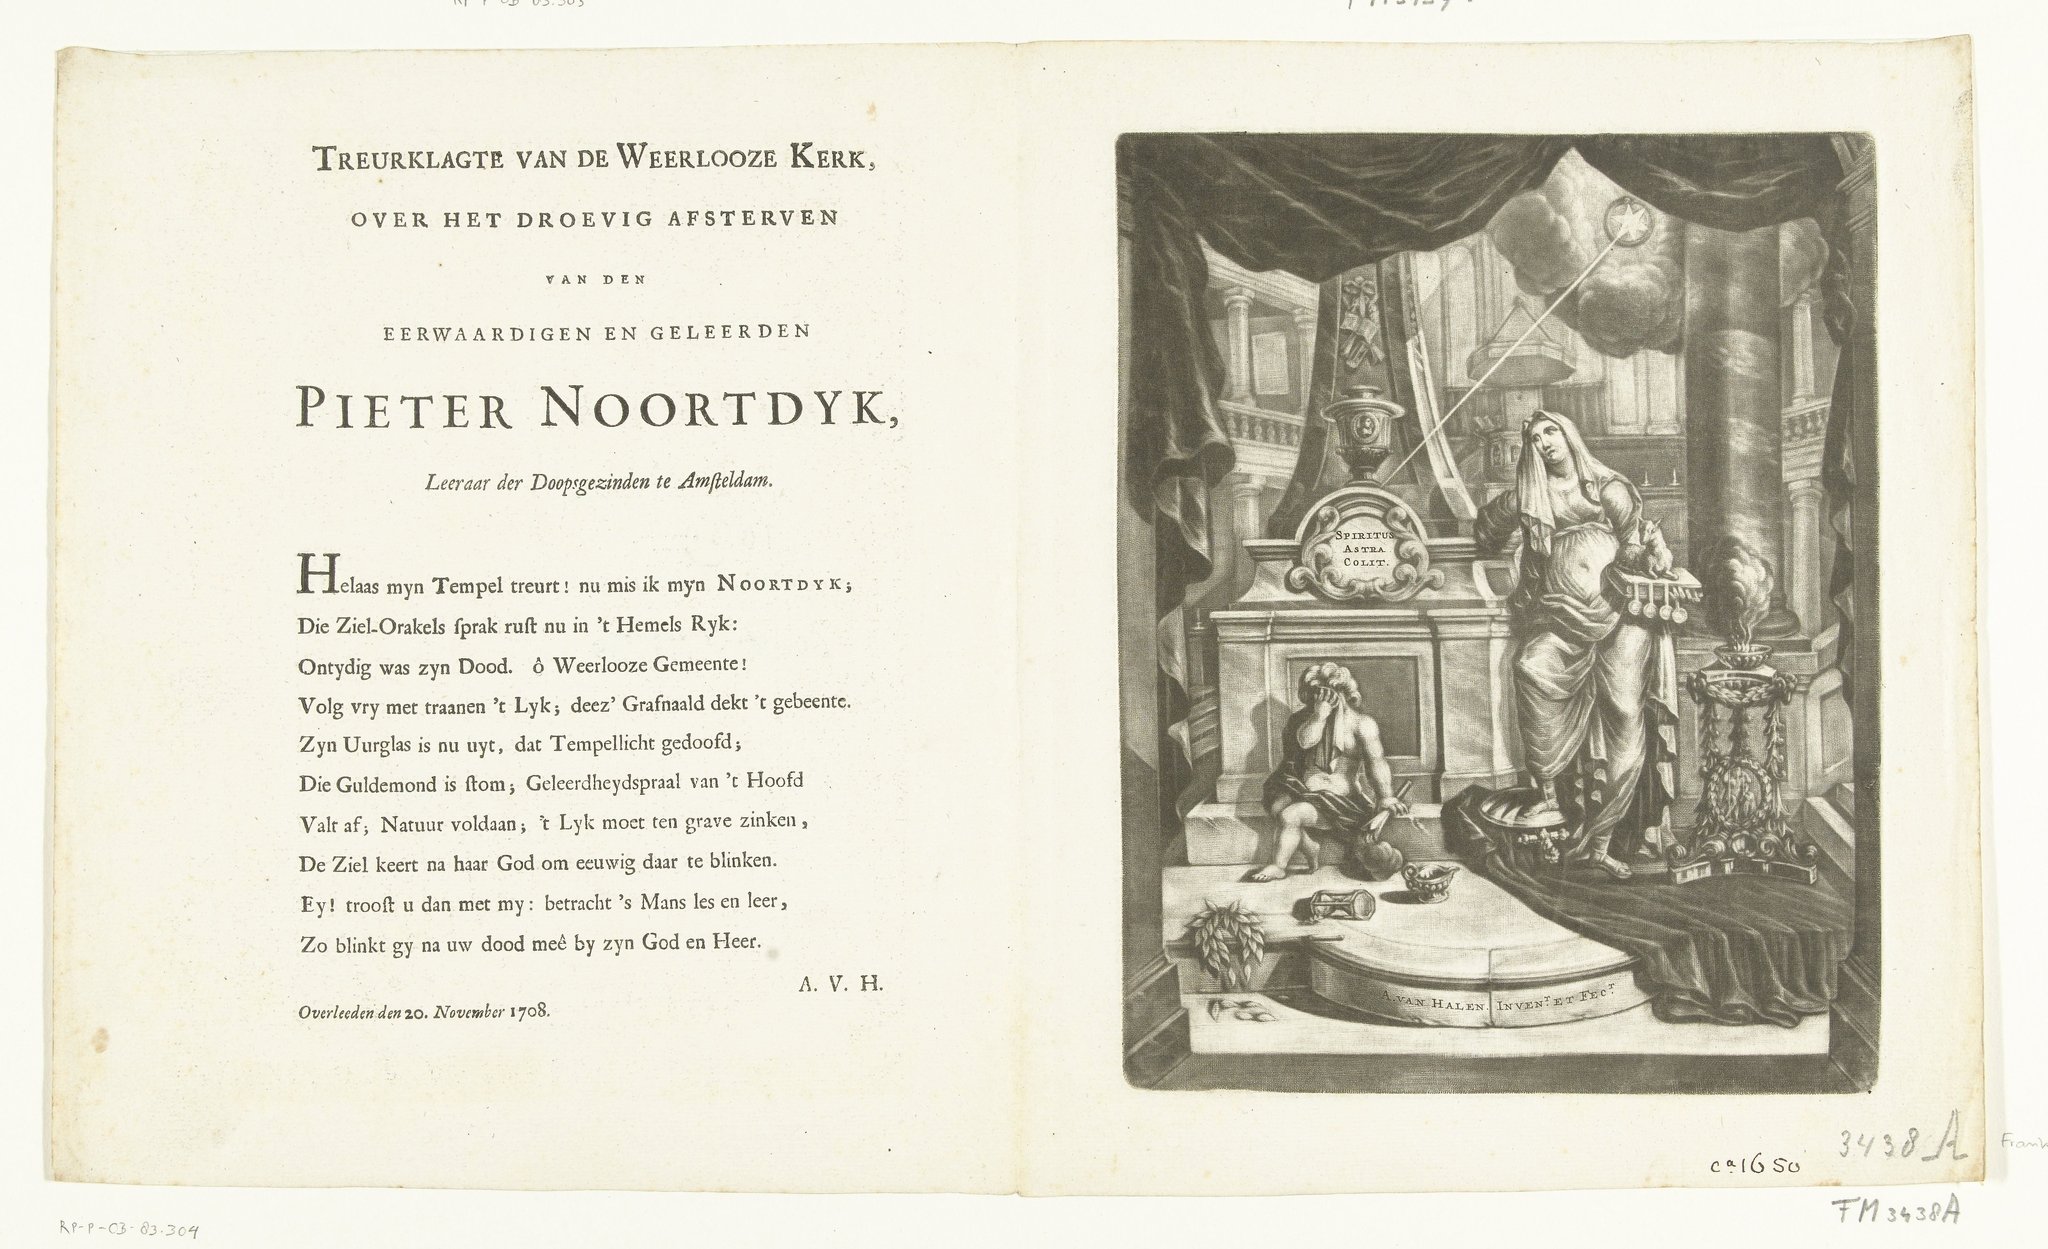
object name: print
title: Treurklagte van de Weerloze Kerk, over het droevig afsterven van den eerwaardigen en geleerden Pieter Noortdyk, Leeraar der Doopsgezinden te Amsteldam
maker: arnoud van halen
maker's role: draughtsman, painter, print maker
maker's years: 1673-1732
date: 1708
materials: paper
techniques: letterpress printing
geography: northern netherlands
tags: faith, 'fides'; 'fede', 'fede catholica', 'fede christiana', 'fede christiana catholica' (ripa) ~ one of the three theological virtues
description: Prent en vers op het overlijden van de voorganger bij de doopsgezinden te Amsterdam Pieter Noortdyk, 20 november 1708. Vouwblad met links een vers van 10 regels op het overlijden, rechts het Geloof treurend bij een grafmonument in een kerk.